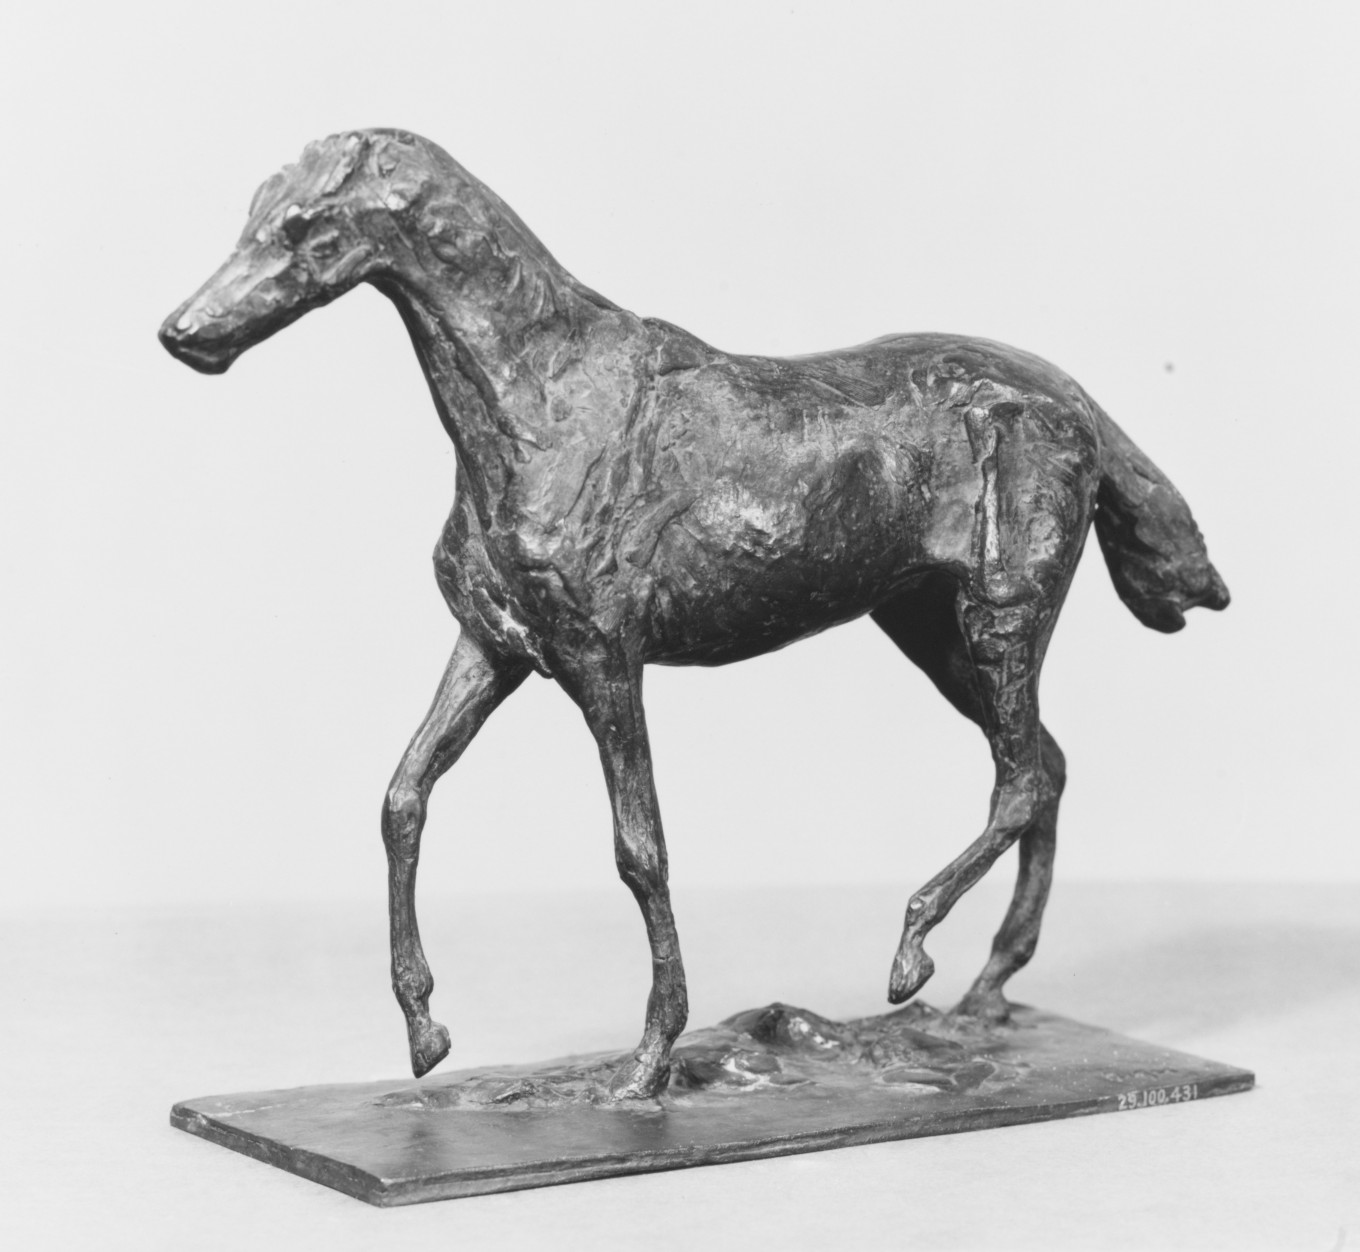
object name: statuette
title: Horse Walking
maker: edgar degas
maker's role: artist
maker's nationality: french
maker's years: 1834-1917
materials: bronze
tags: horses